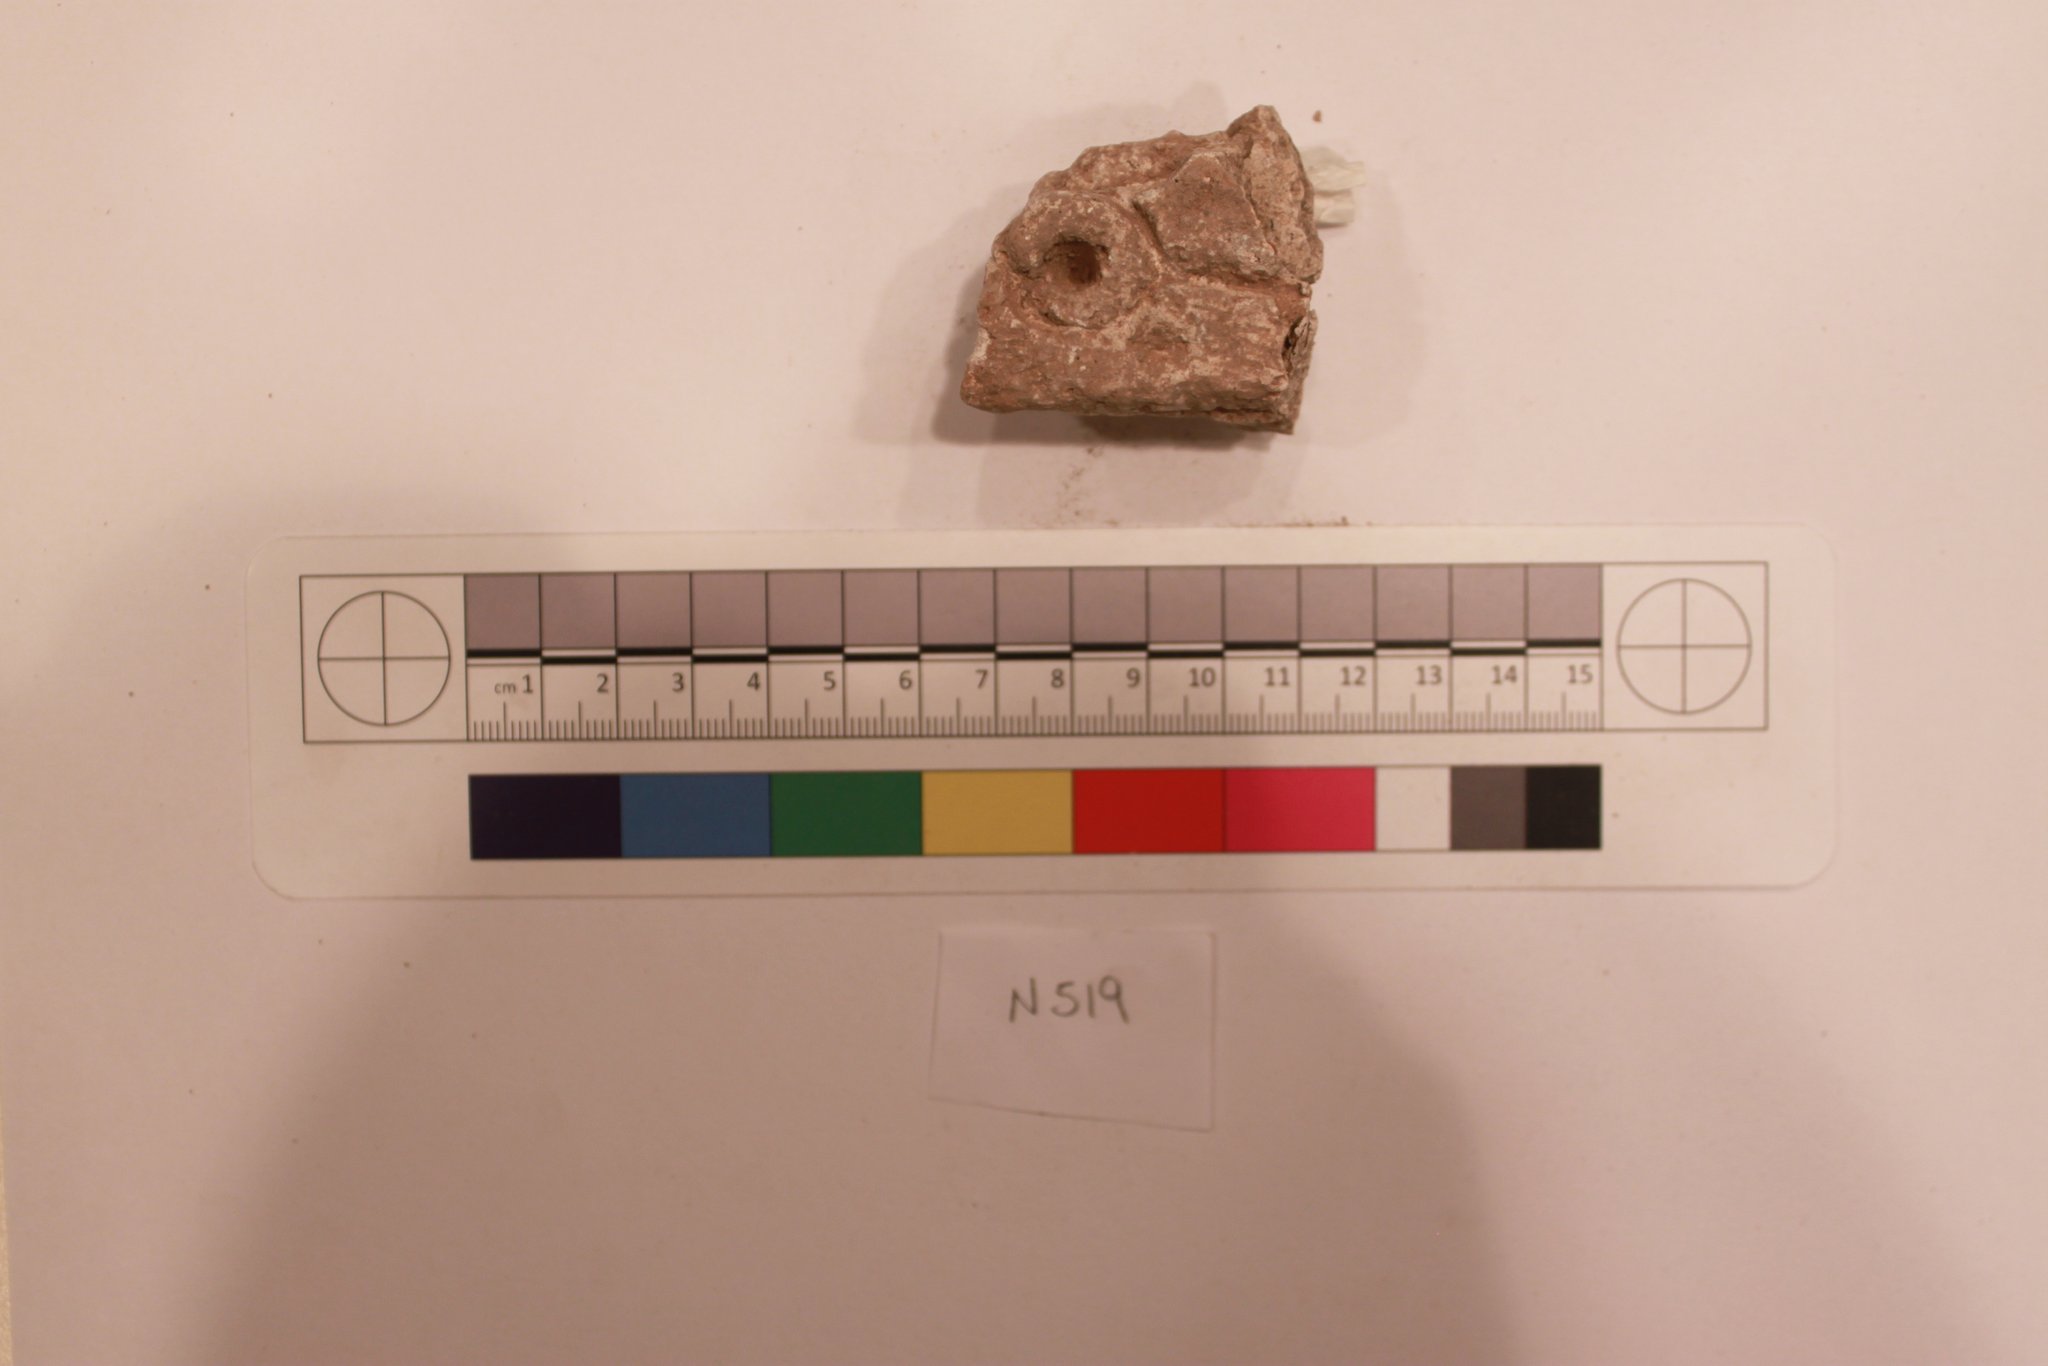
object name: fragment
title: Stucco Fragment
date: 701-1200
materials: plaster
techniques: carving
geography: iran